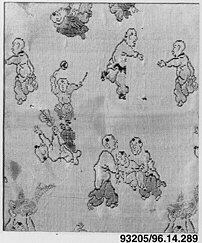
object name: piece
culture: japanese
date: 1701-1900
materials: silk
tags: boys,men